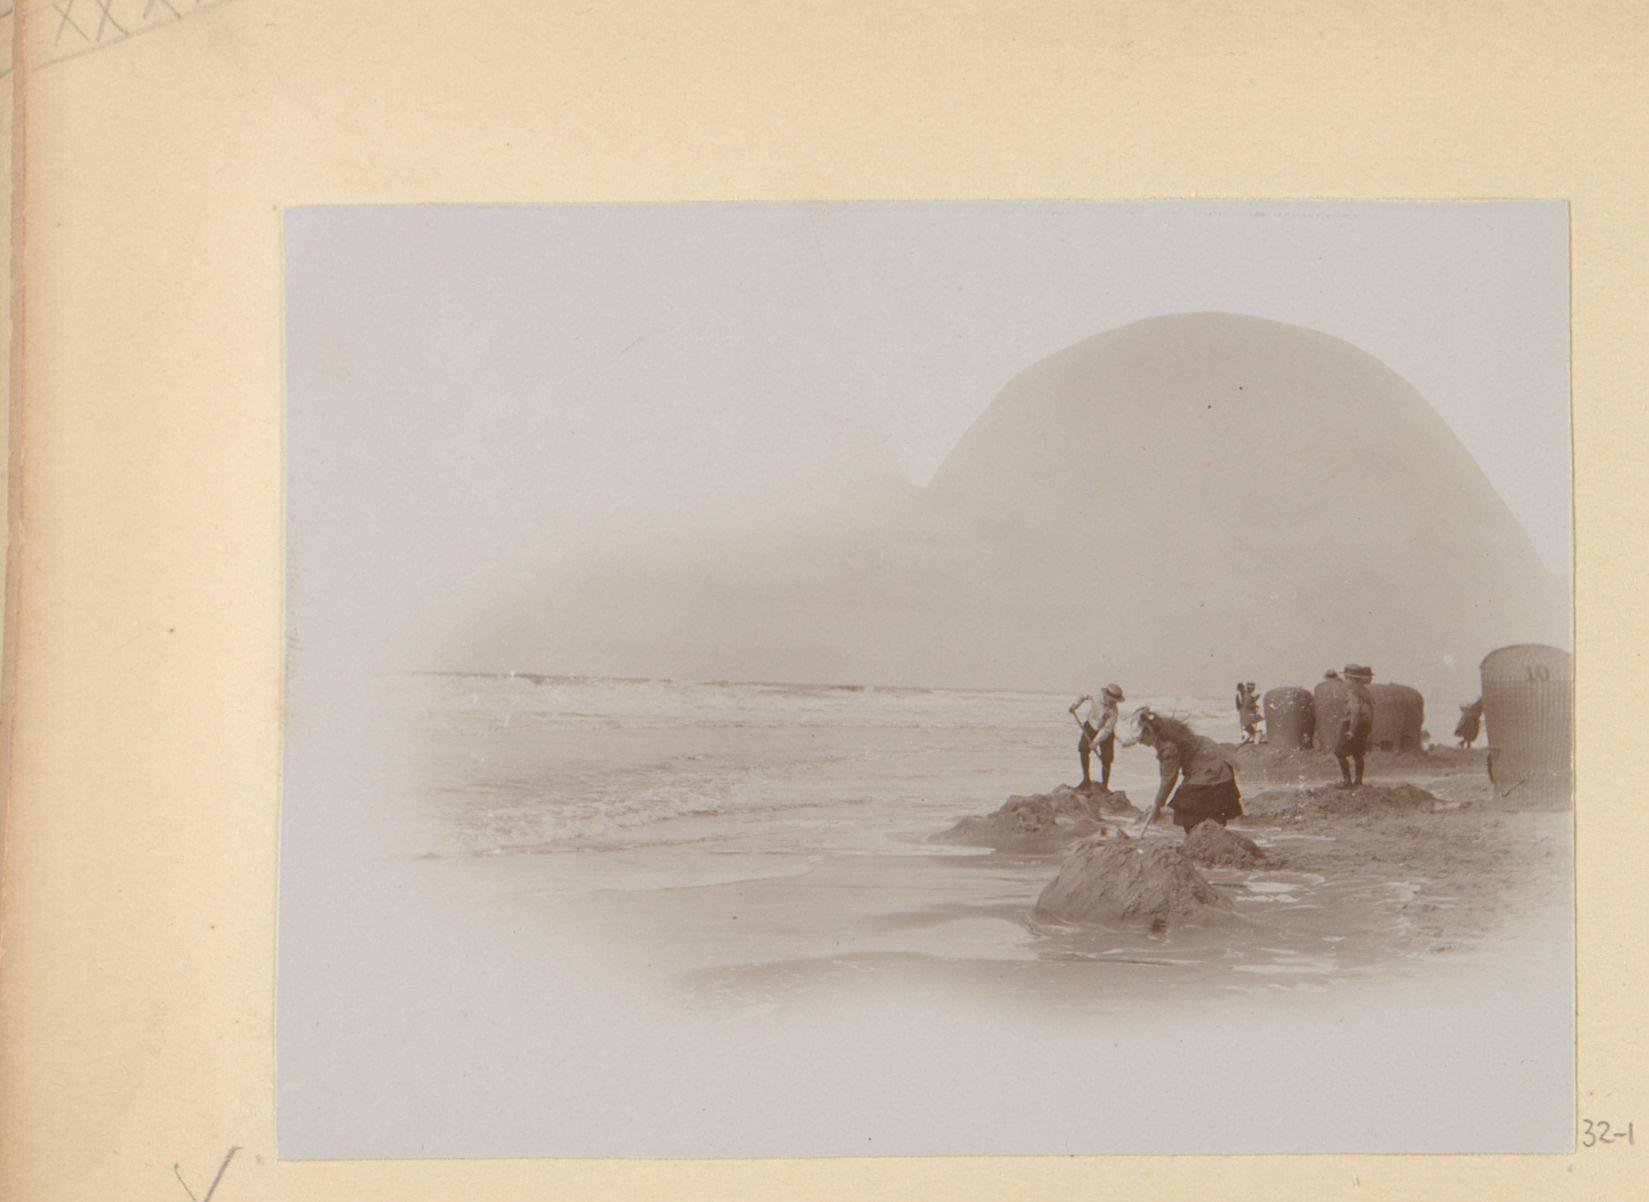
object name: album leaf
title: Zandkastelen bouwen op het strand van Scheveningen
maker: hendrik herman van den berg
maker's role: amateurfotograaf, jurist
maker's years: 1875-1944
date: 1890-1894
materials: paper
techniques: collodion silver print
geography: scheveningen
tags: beach (as place of recreation)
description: Foto 1 op albumblad 32 uit album "Amsterdam 1890-1894".